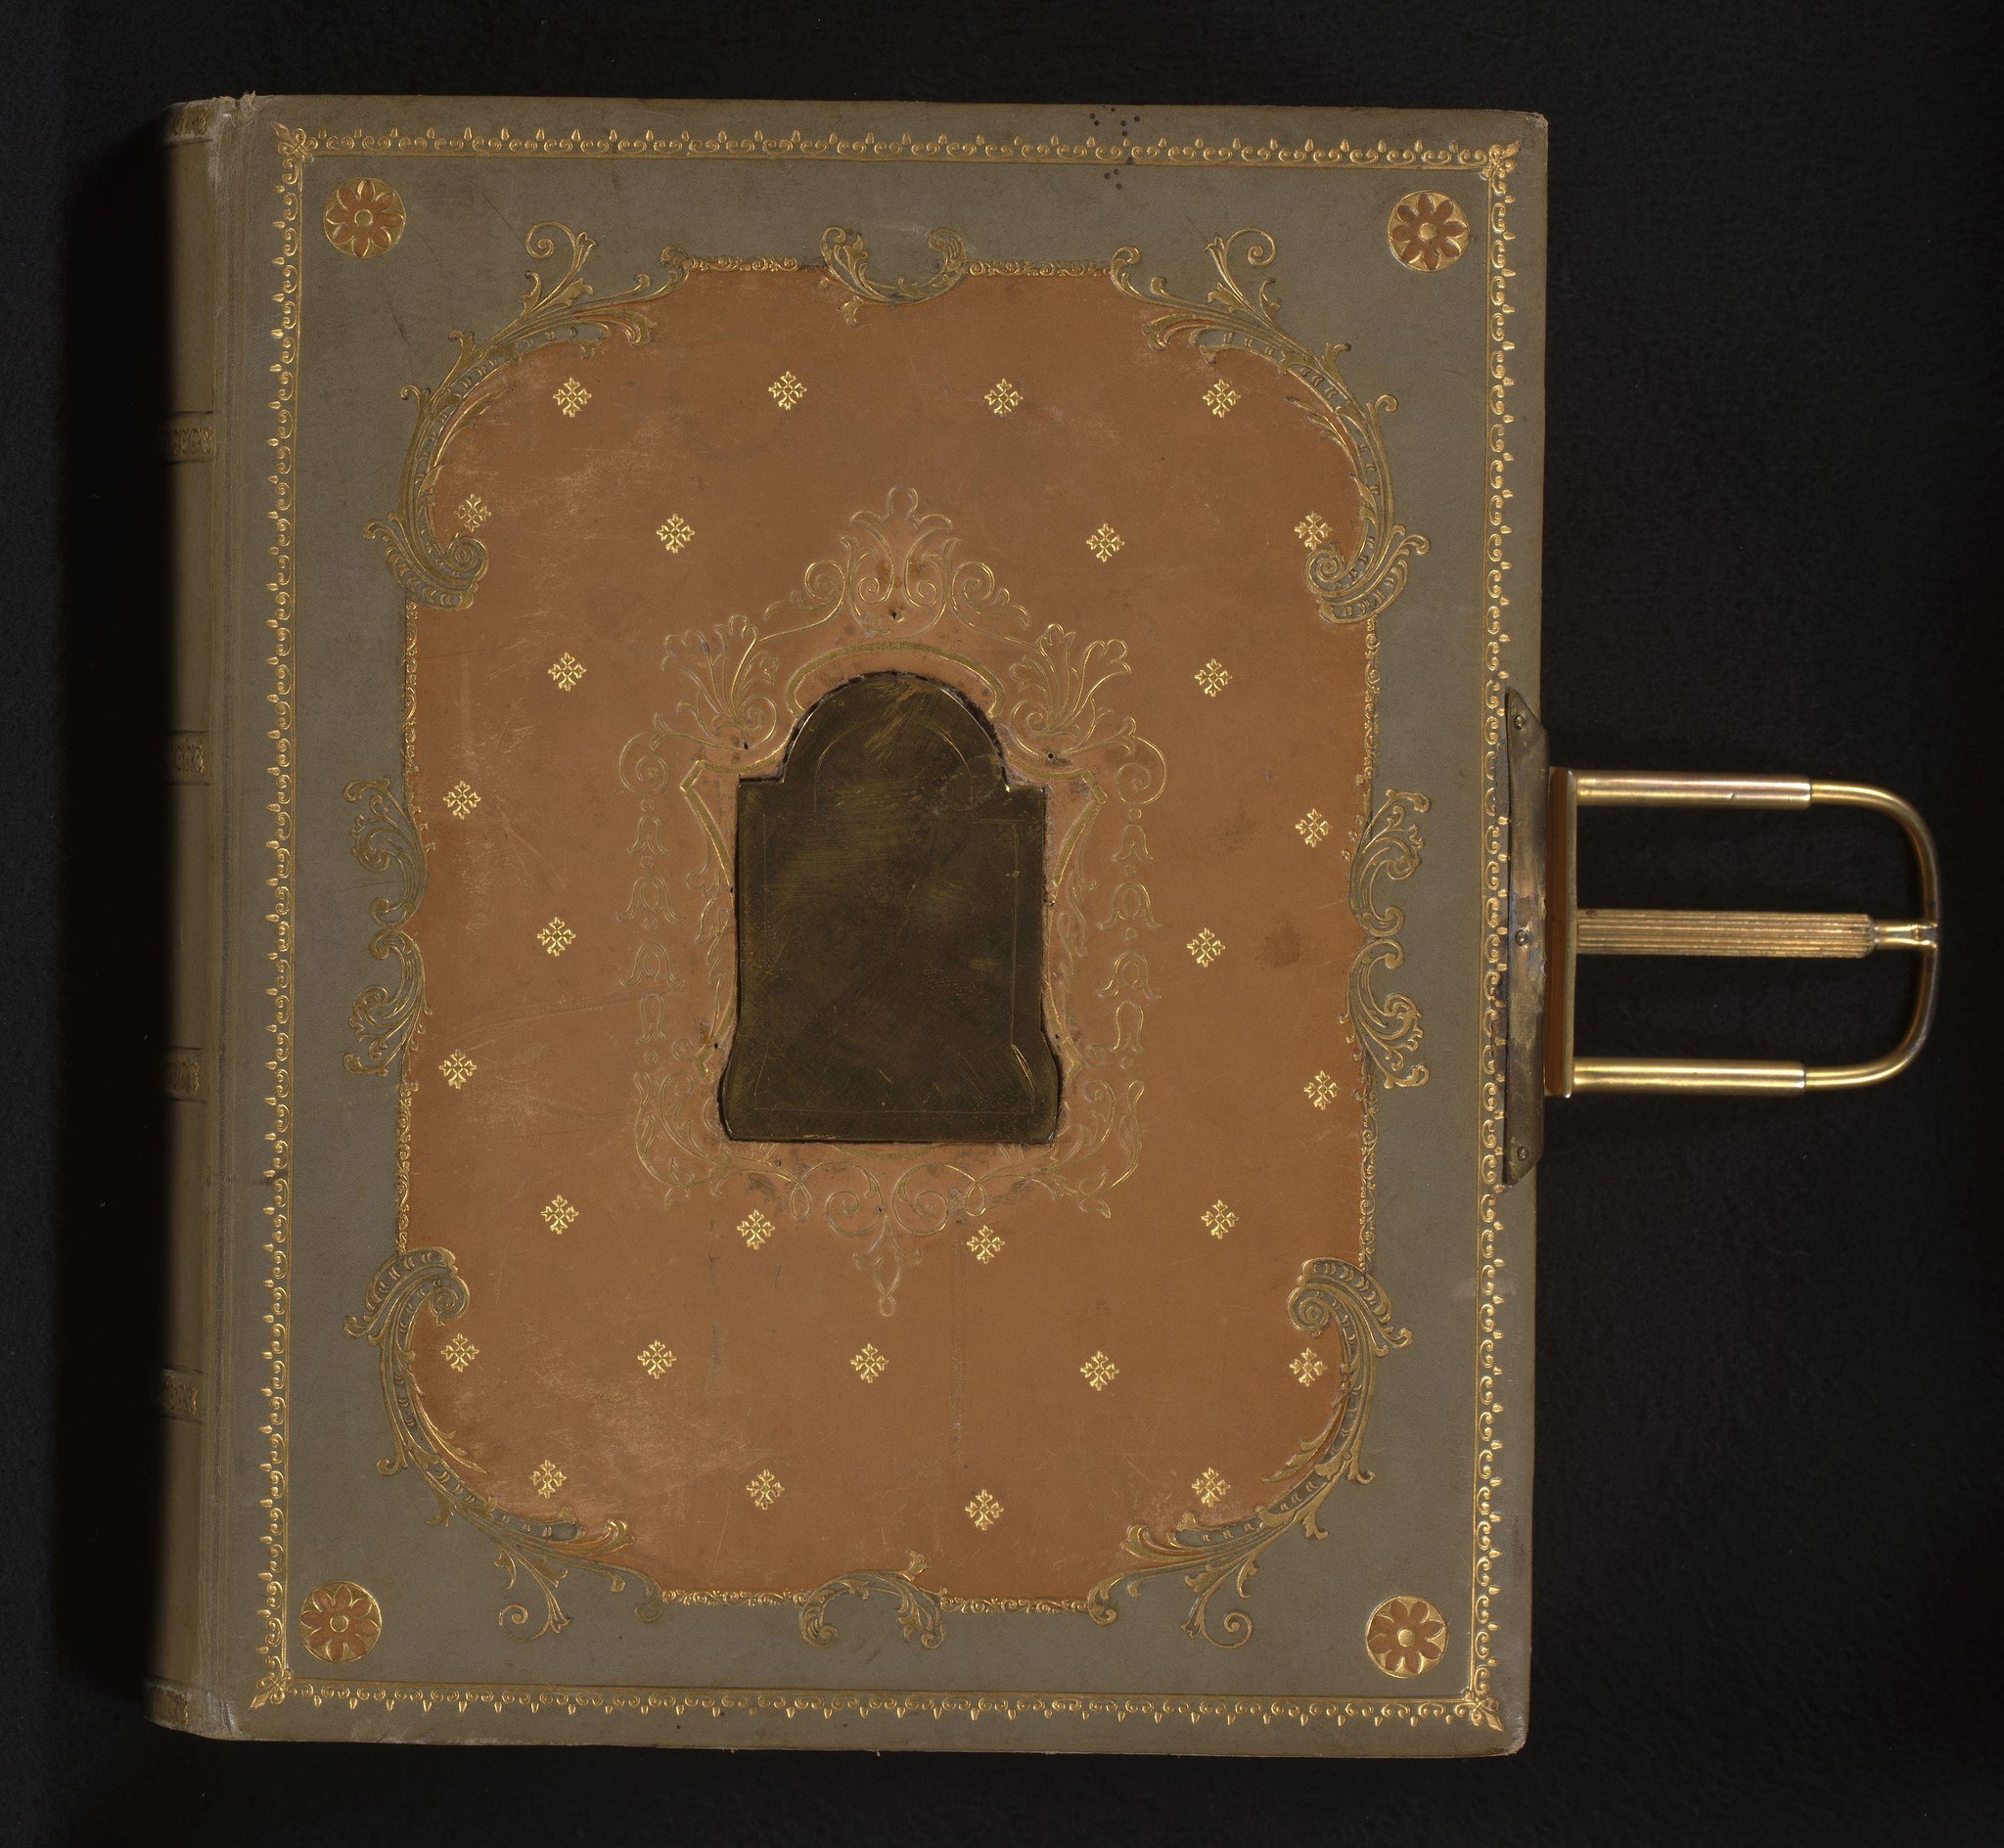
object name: photograph album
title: Nederlands familiealbum met 64 foto's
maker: Anonymous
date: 1870-1920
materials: cardboard, copper, leather, photographic support, silk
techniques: albumen print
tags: adult woman, parents with their children, adult man, child, historical persons, dog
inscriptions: inscription: ‘August Klein Wien Nur Graben 20’, inscription: ‘Dienst/ Verspreide/ Rijkskollekties (...)’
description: Fotoalbum met 40 pagina's en in totaal 64 foto's. Het album bevat cartes-de-visite en kabinetfoto's, voornamelijk portretten van een familie.